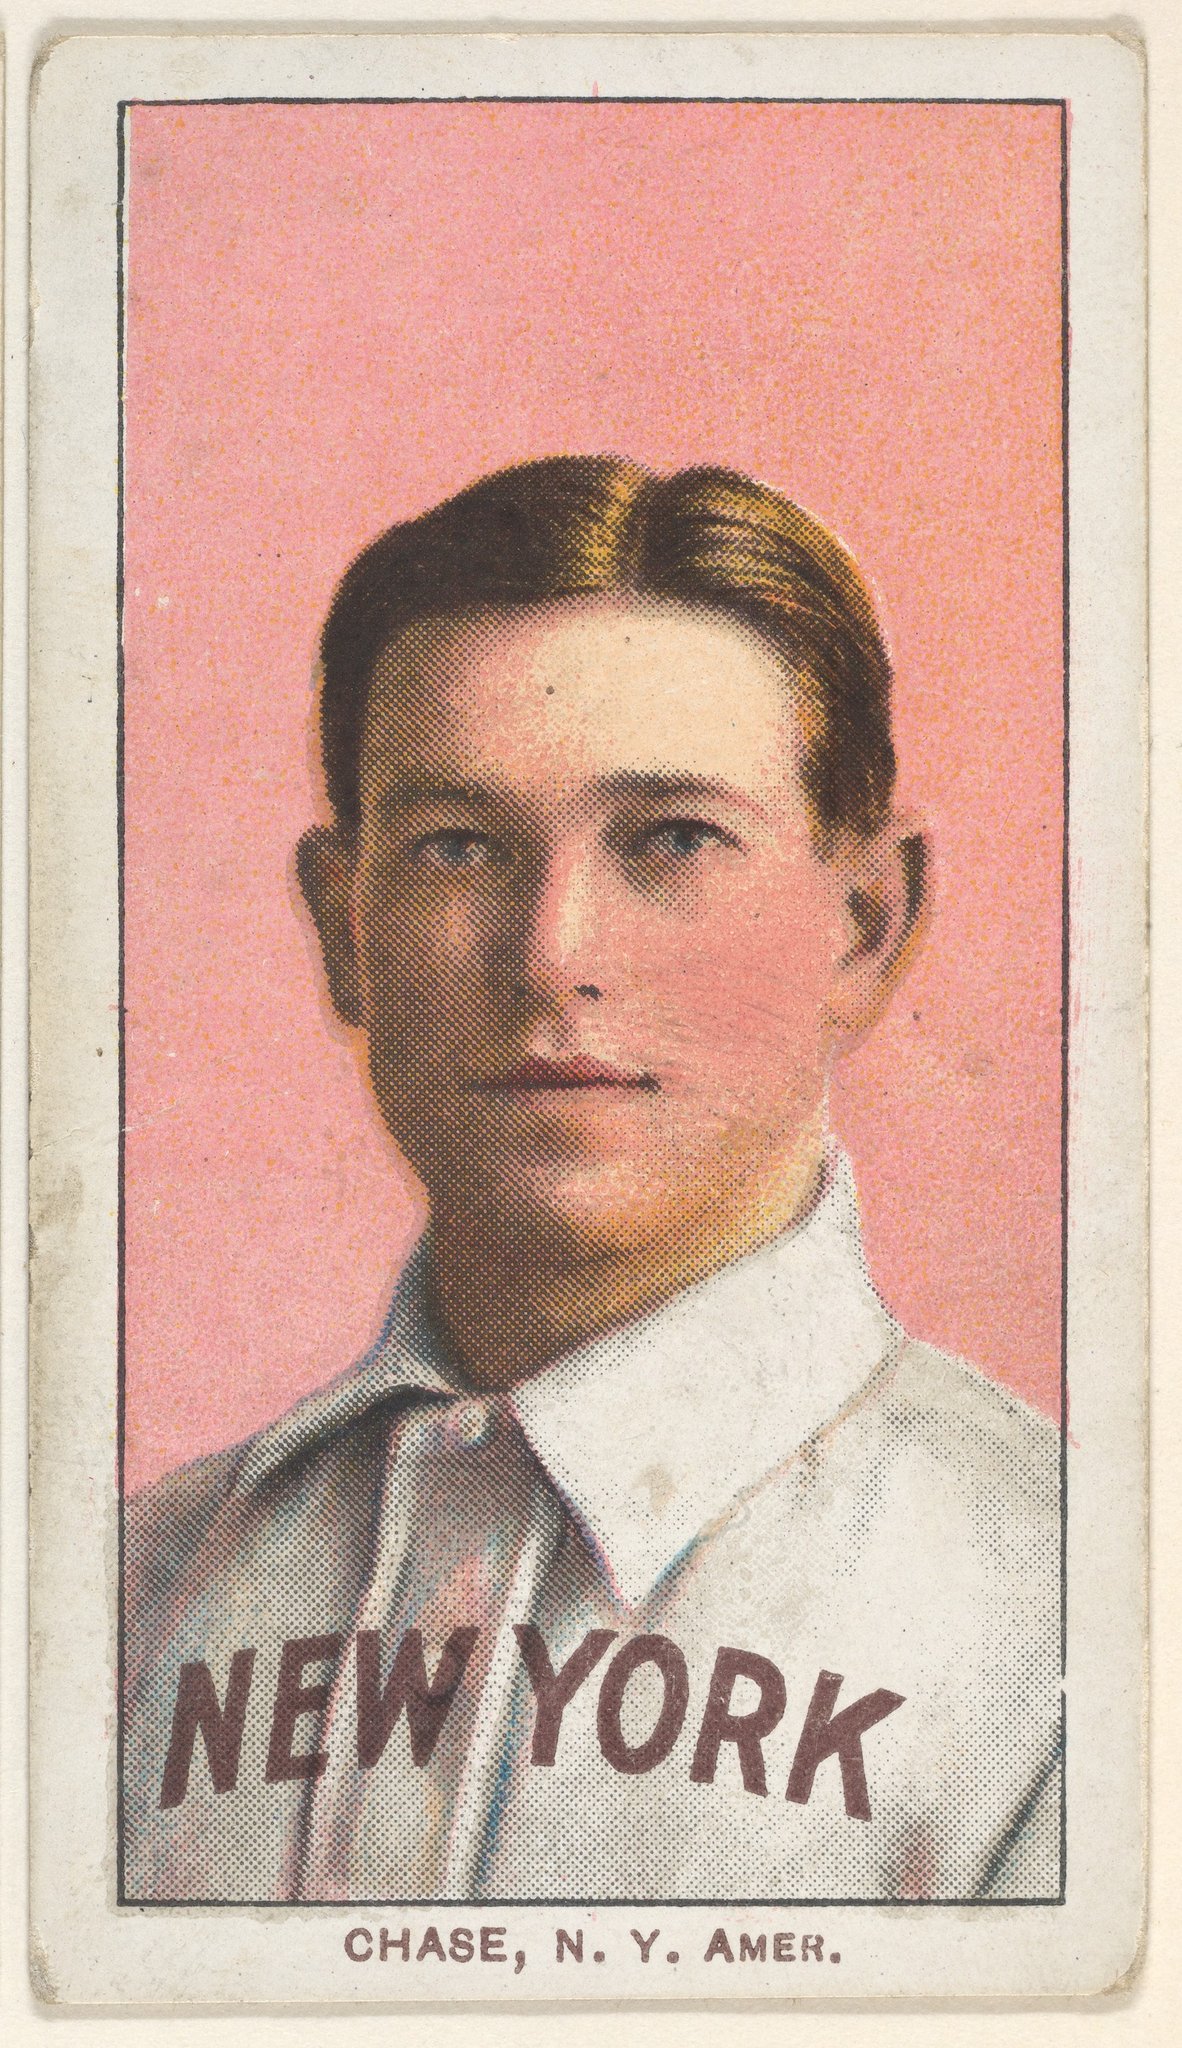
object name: baseball card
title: Chase, New York, American League, from the White Border series (T206) for the American Tobacco Company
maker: american tobacco company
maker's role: publisher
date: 1909-1911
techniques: lithography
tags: men,baseball,athletes